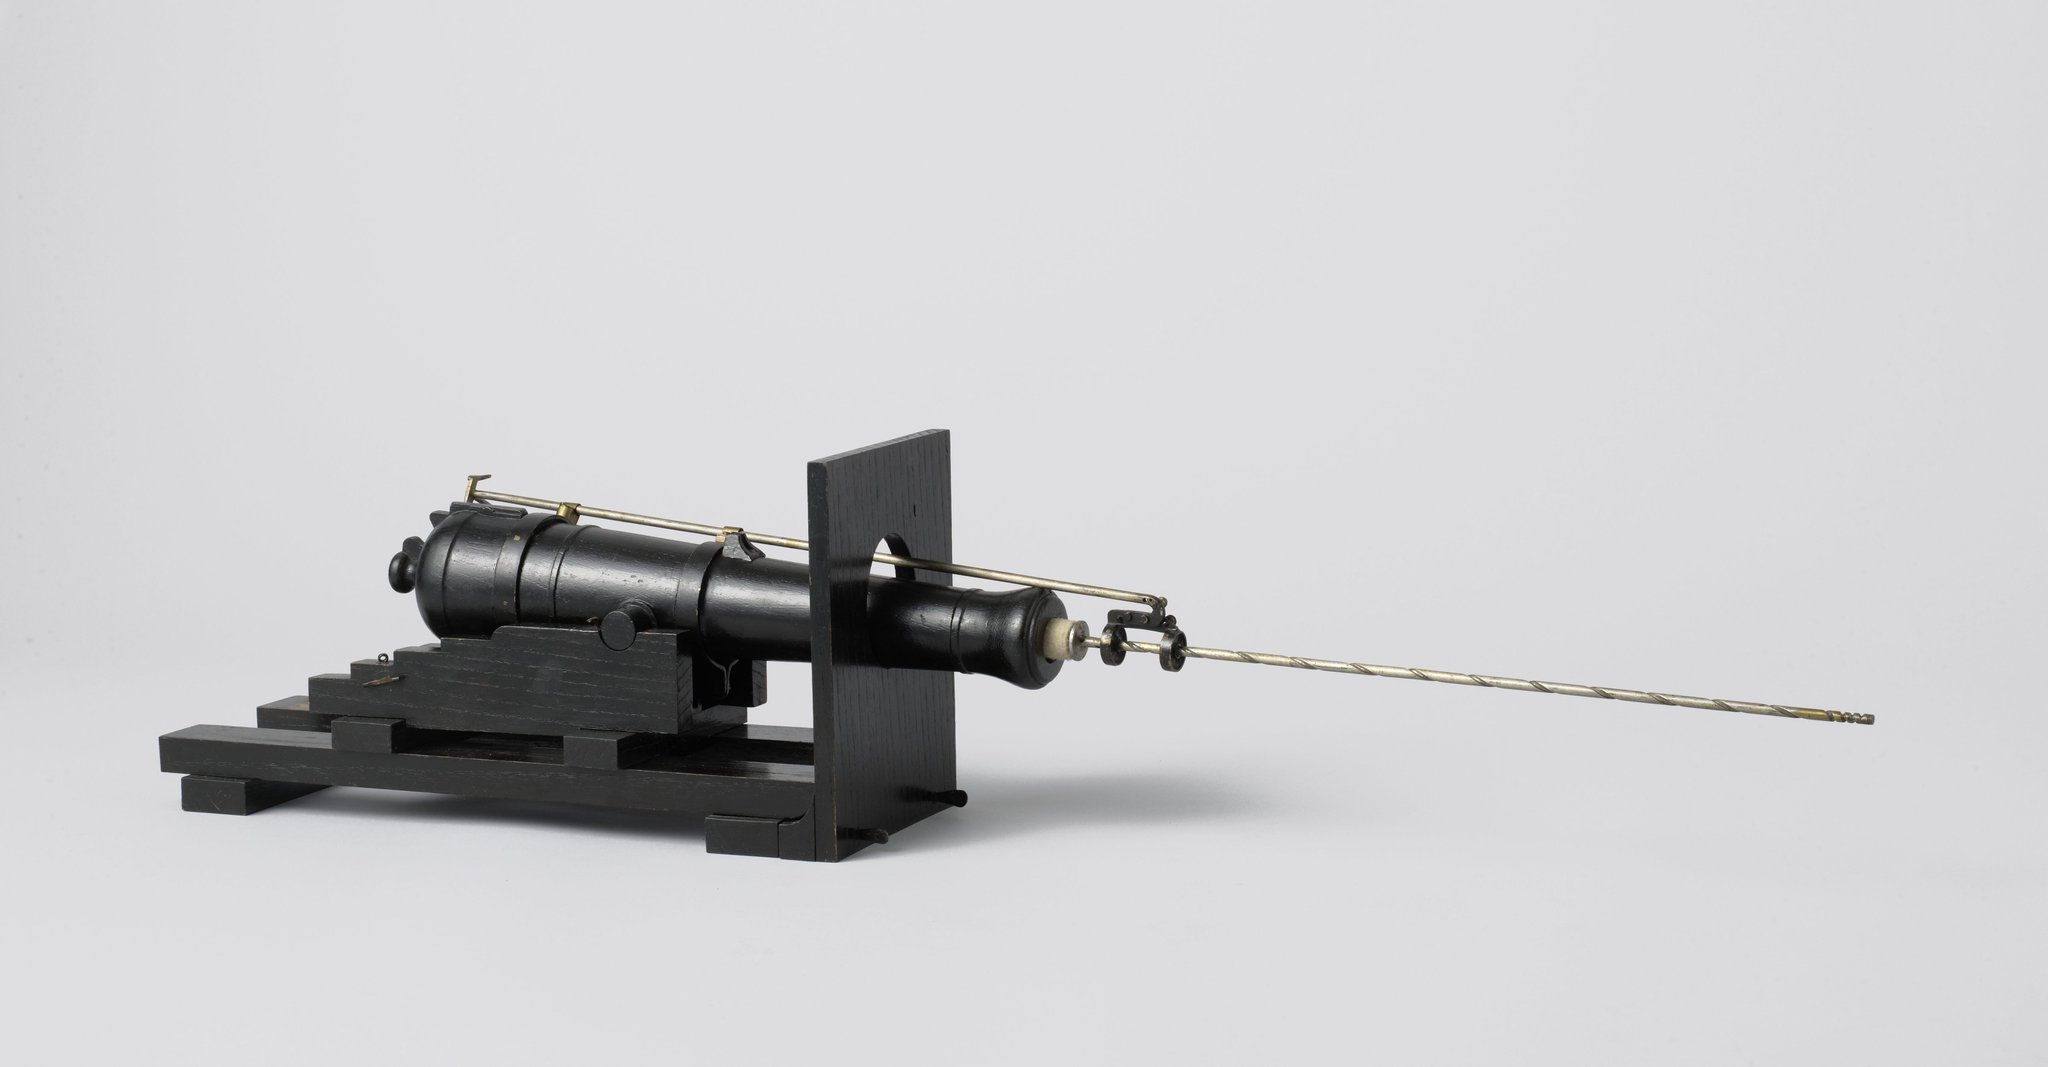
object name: demonstration model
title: Model of a 60-Pounder Muzzle-Loading Gun with Loading Gear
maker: van de weetering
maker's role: model maker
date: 1863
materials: brass, iron, textile, wood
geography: netherlands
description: Model van een lang kanon van 60 pond op schuifslede, met een nieuw ontwerp laadgerei, op scheepsdeel met geschutpoort, incompleet. Het model is, op enkele metalen onderdelen na, geheel zwart geverfd. De houten loop is 35,8 cm lang en heeft een kaliber van 20,5 mm; hij is voorzien van een slotverhevenheid en een vizierhouder op het tappenstuk. Het affuit bestaat uit twee wangen met vier trappen, verbonden door twee aslijven zonder wielen, en een zoolplaat. De geschutpoort is ovaal. Met beugels is het laadgerei aan de loop bevestigd: het bestaat uit een wisser met een steel, die gaat door twee geleiders aan het eind van een lange stang. In de steel is een spiraalvormige groef aangebracht, waarin een touw gelegd wordt dat de roterende beweging aan de wisser geeft. Deze stang is aan de beugels op de loop bevestigd en heeft achteraan handvaten waarmee door the draaien de wisser direct voor de monding gebracht kan worden, of naast het kanon zodat het door de geschutpoort naar binnen gehaald kan worden. Het takel, dat over drie ogen bij de geleiders op de stang moet lopen, en andere onderdelen waarmee de wisser bediend moet worden, ontbreken. Schaal 1:10 (Obreen).